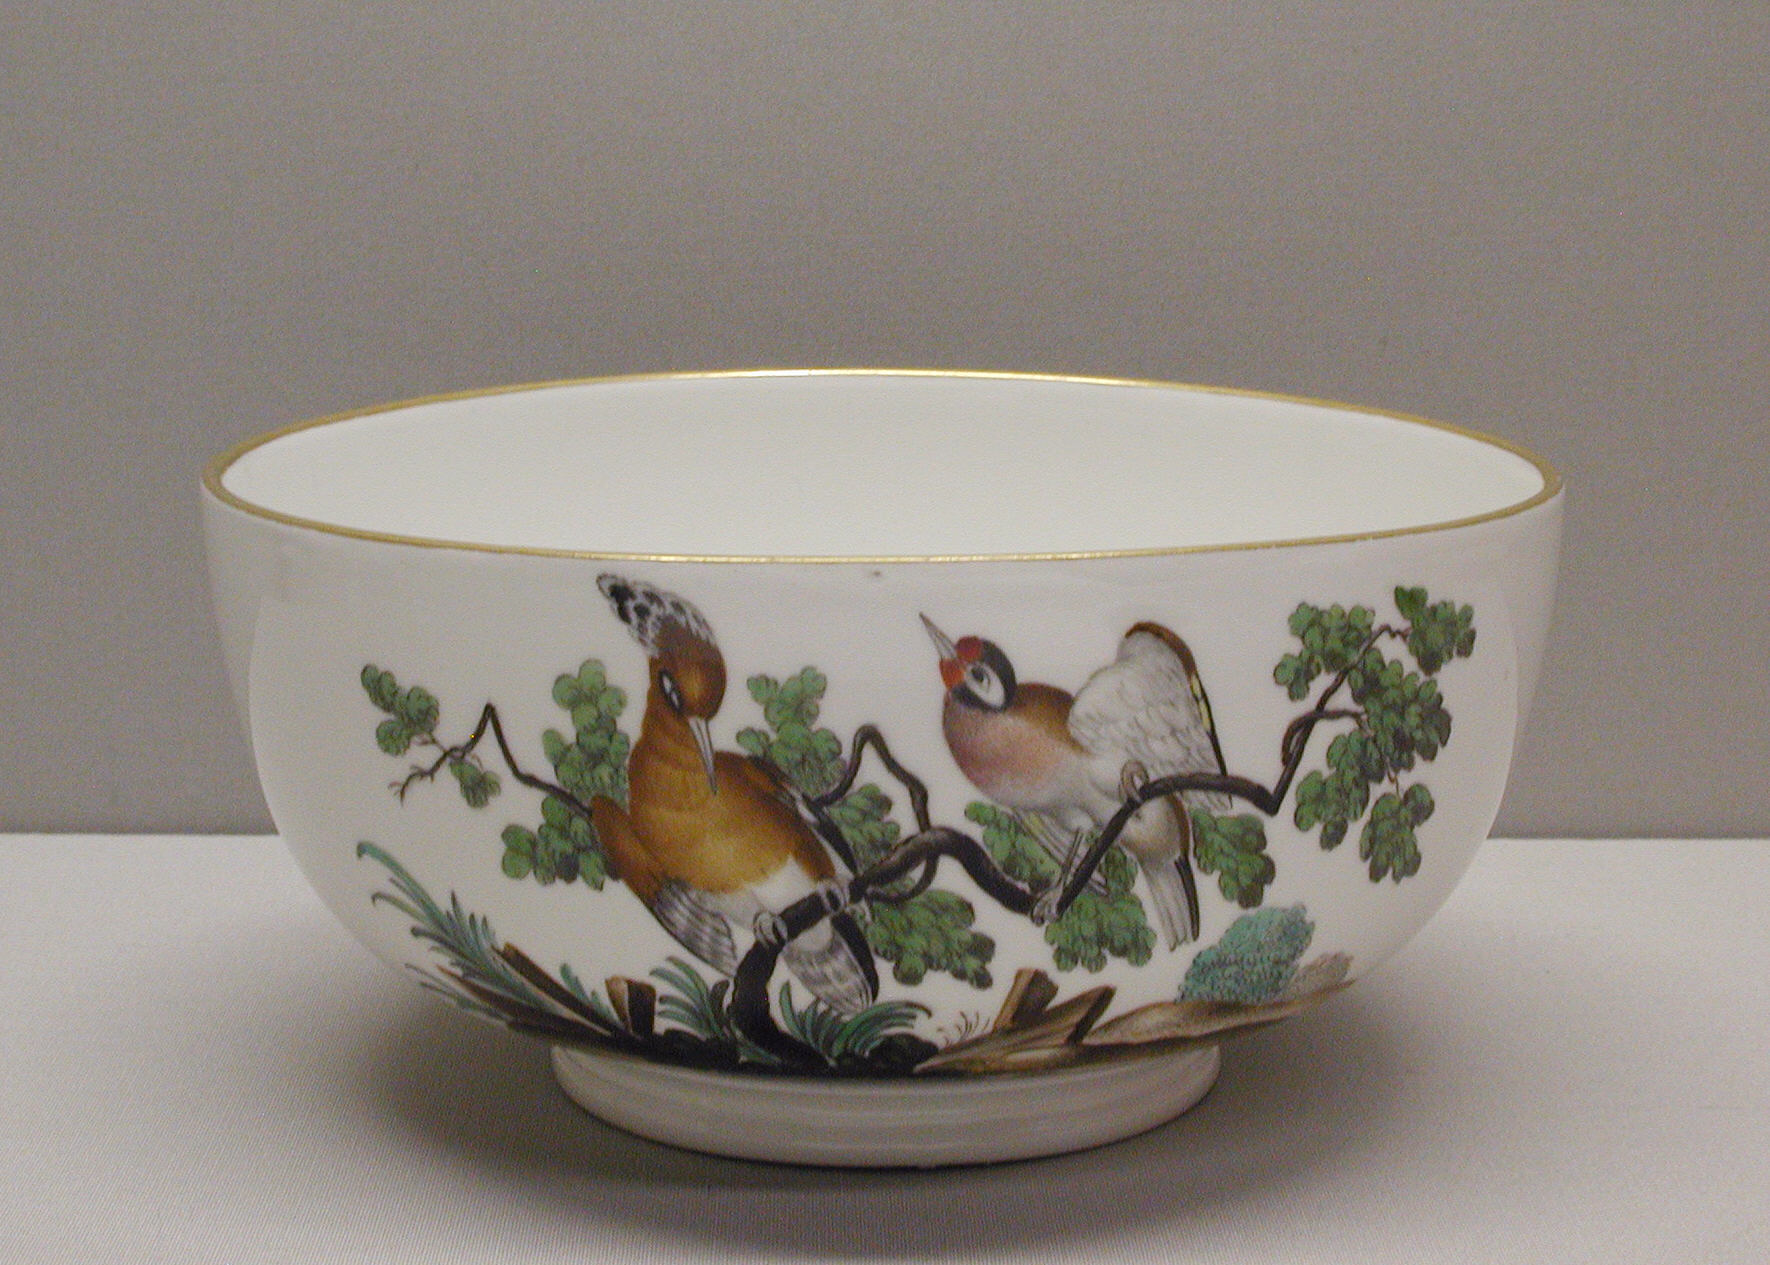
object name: waste bowl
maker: höchst manufactory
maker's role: manufactory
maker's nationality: german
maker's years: 1746-1796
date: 1775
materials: hard paste porcelain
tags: birds,plants